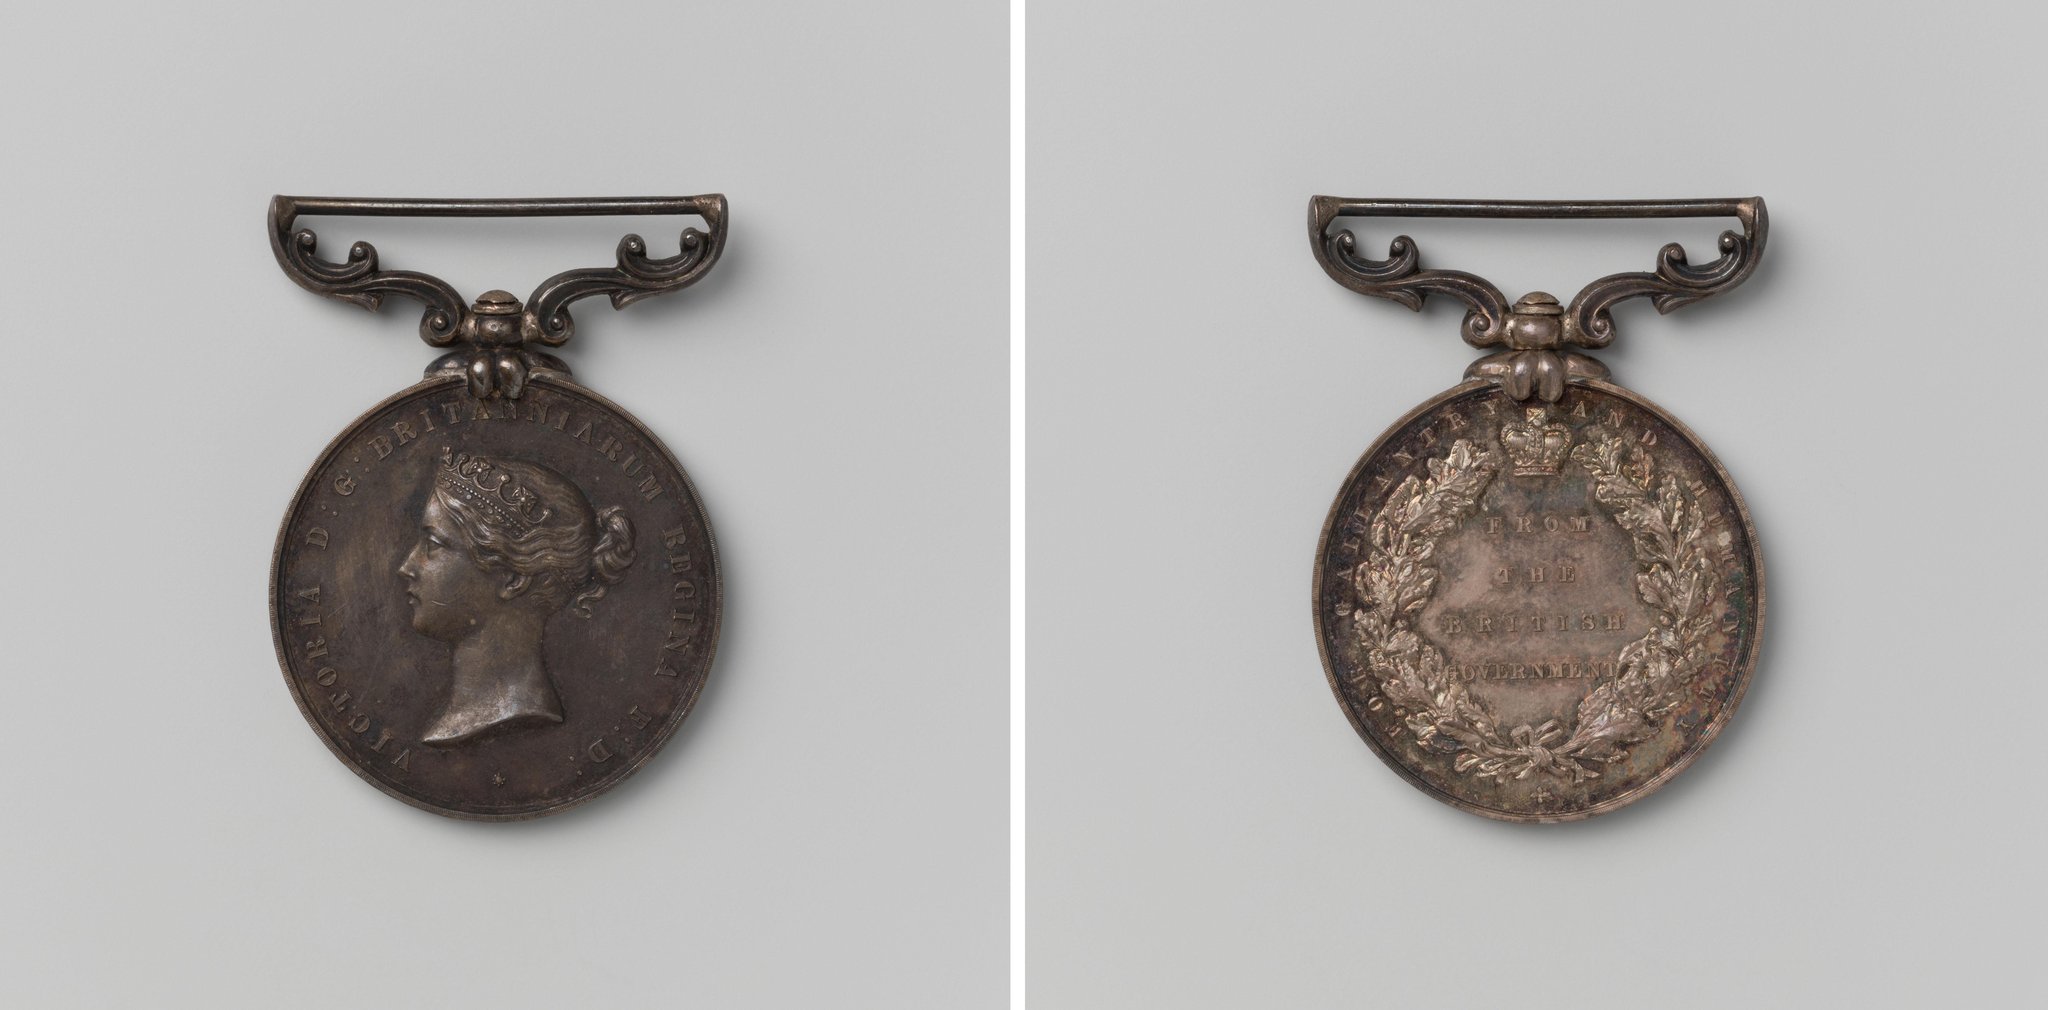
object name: honorary medal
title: Britse regering, penning uitgereikt aan Willem Broeks wegens menslievendheid, ter ere van Victoria, koningin van Groot-Britannie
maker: leonard charles wyon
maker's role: medailleur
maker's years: 1826-1891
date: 1859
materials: silver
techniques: engraving, striking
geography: london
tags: victoria (koningin van het verenigd koninkrijk en keizerin van india)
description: Zilveren penning aan versierd, langwerpig hangertje. Voorzijde: borststuk vrouw binnen omschrift. Keerzijde: opschrift onder kroon binnen eikekrans en omschrift; randschrift